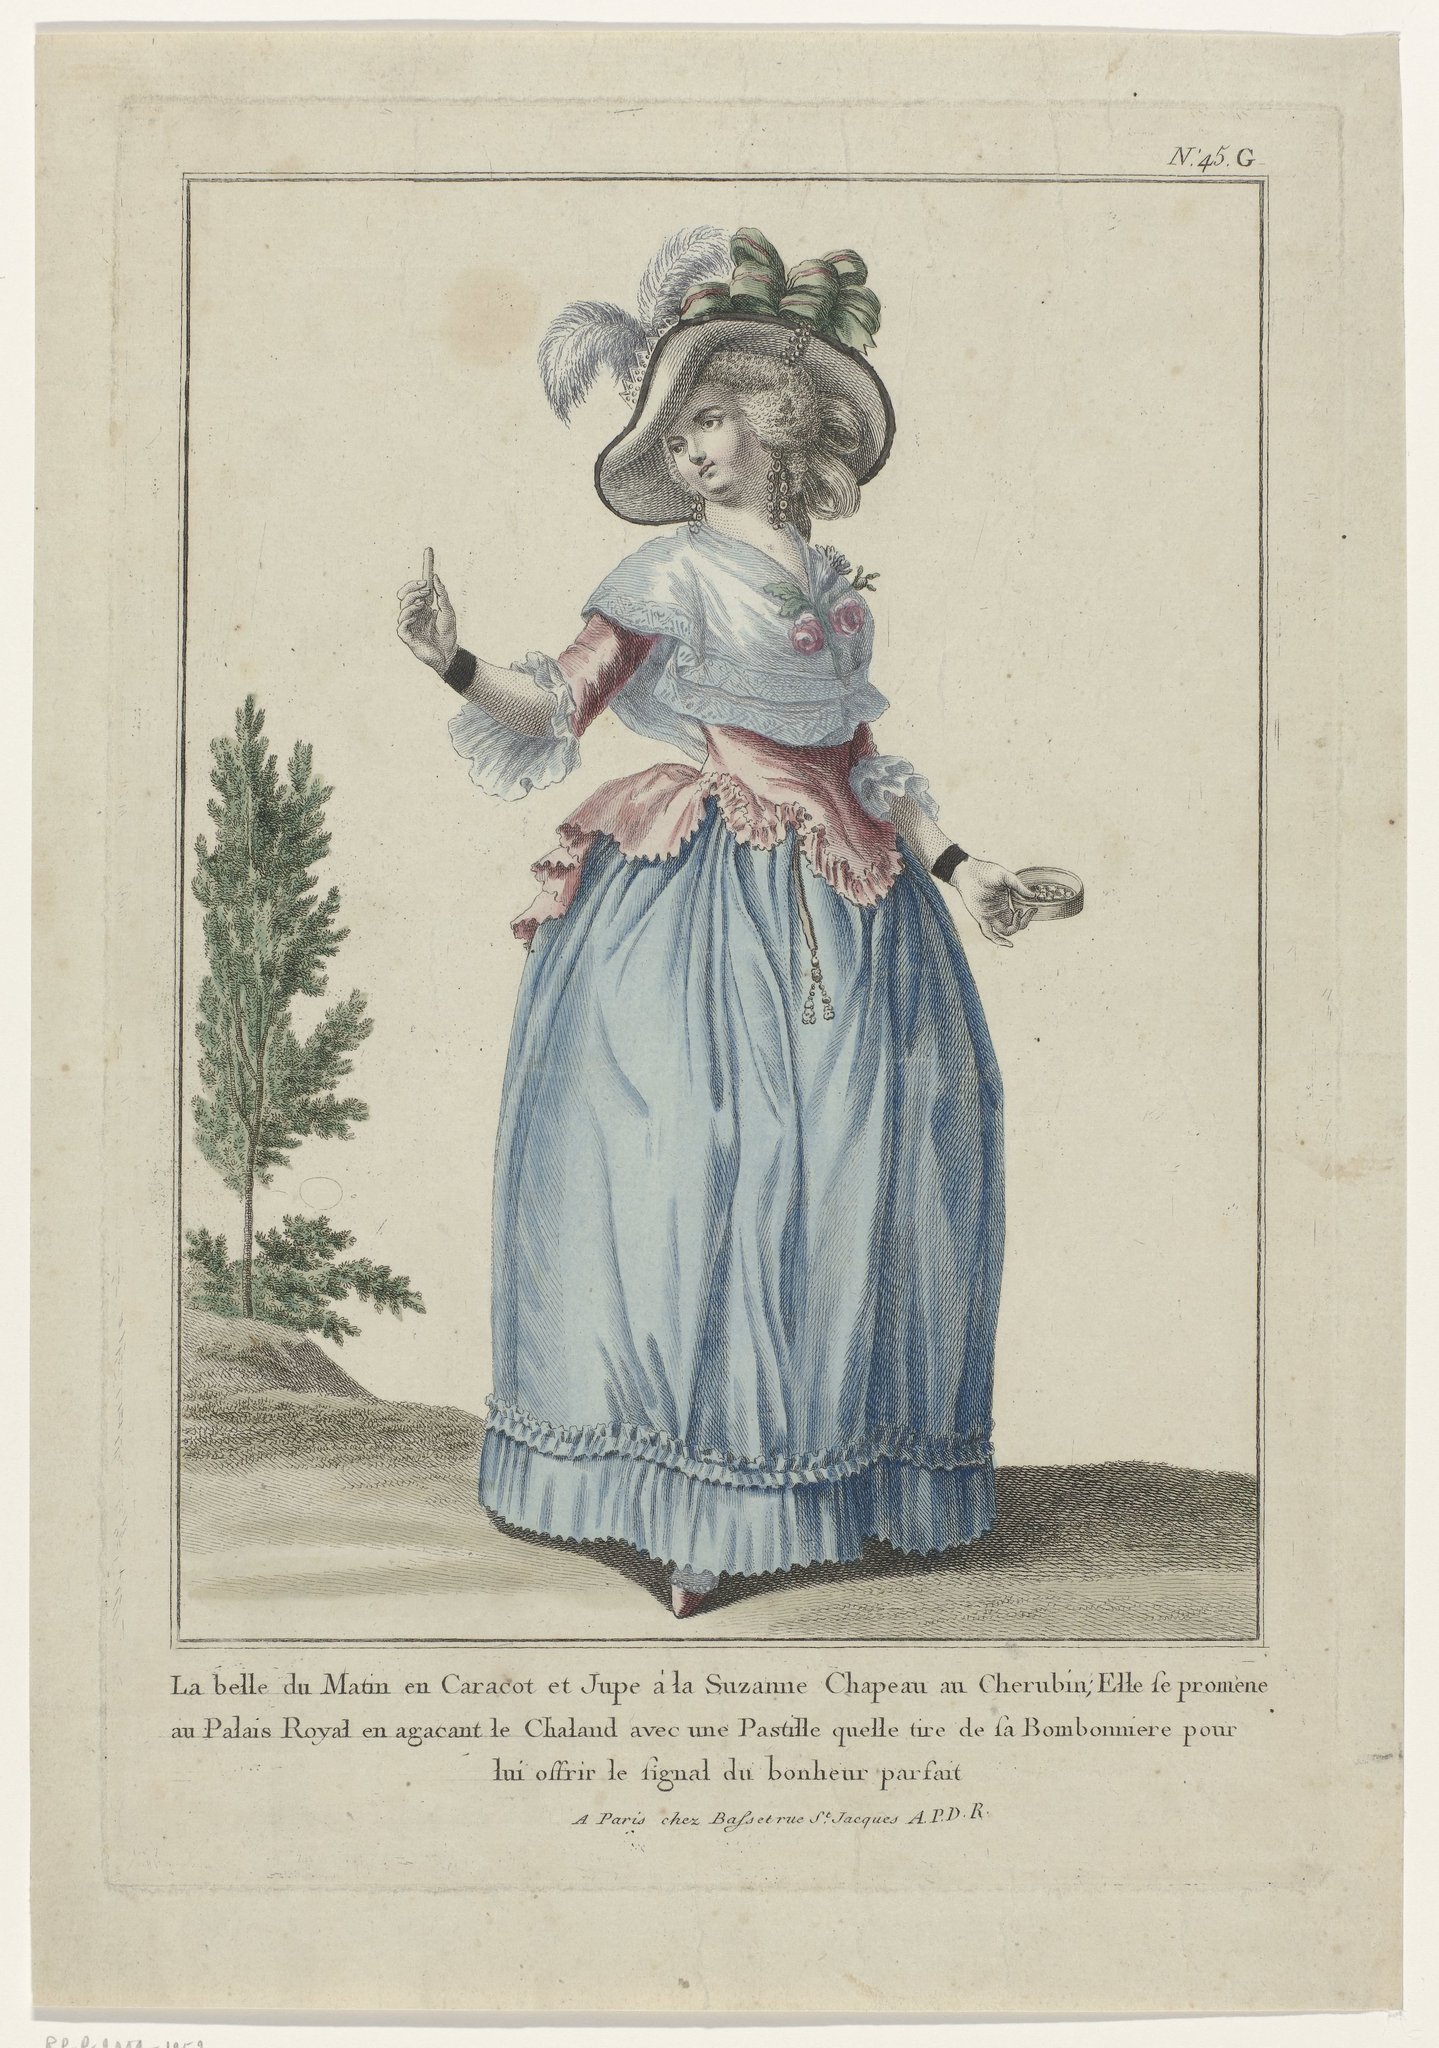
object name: fashion print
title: La belle du Matin en Caracot et Jupe á la Suzanne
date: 1785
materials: paper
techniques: engraving, hand coloring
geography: paris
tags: corsage (+ women's clothes), clothing for the upper part of the body (caraco) (+ women's clothes), drugs, fashion plates, head-gear: hat (+ women's clothes), skirt (+ women's clothes), sleeves (+ women's clothes)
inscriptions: caption: ‘La belle du Matin en Caracot et Jupe á la Suzanne Chapeau au Cherubin; Elle se promène au Palais Royal en agacant le Chaland avec une Pastille quelle tire de sa Bombonniere pour lui offrir le signal du bonheur parfait.’, address: ‘A Paris chez Basset rue St. Jacques A. P.D.R.’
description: Vrouw in een caraco en rok 'à la Suzanne'. 'Chapeau au Cherubin'. Zij wandelt in de ochtend naar het Palais Royal; ter afleiding haalt zij een pastille uit haar bonbondoosje. Accessoires: oorbellen, bloemcorsage, armbanden, chatelaine, schoenen. Prent G 45 uit de serie Collection d'Habillements modernes et galants, avec les habillements des princes et seigneurs.